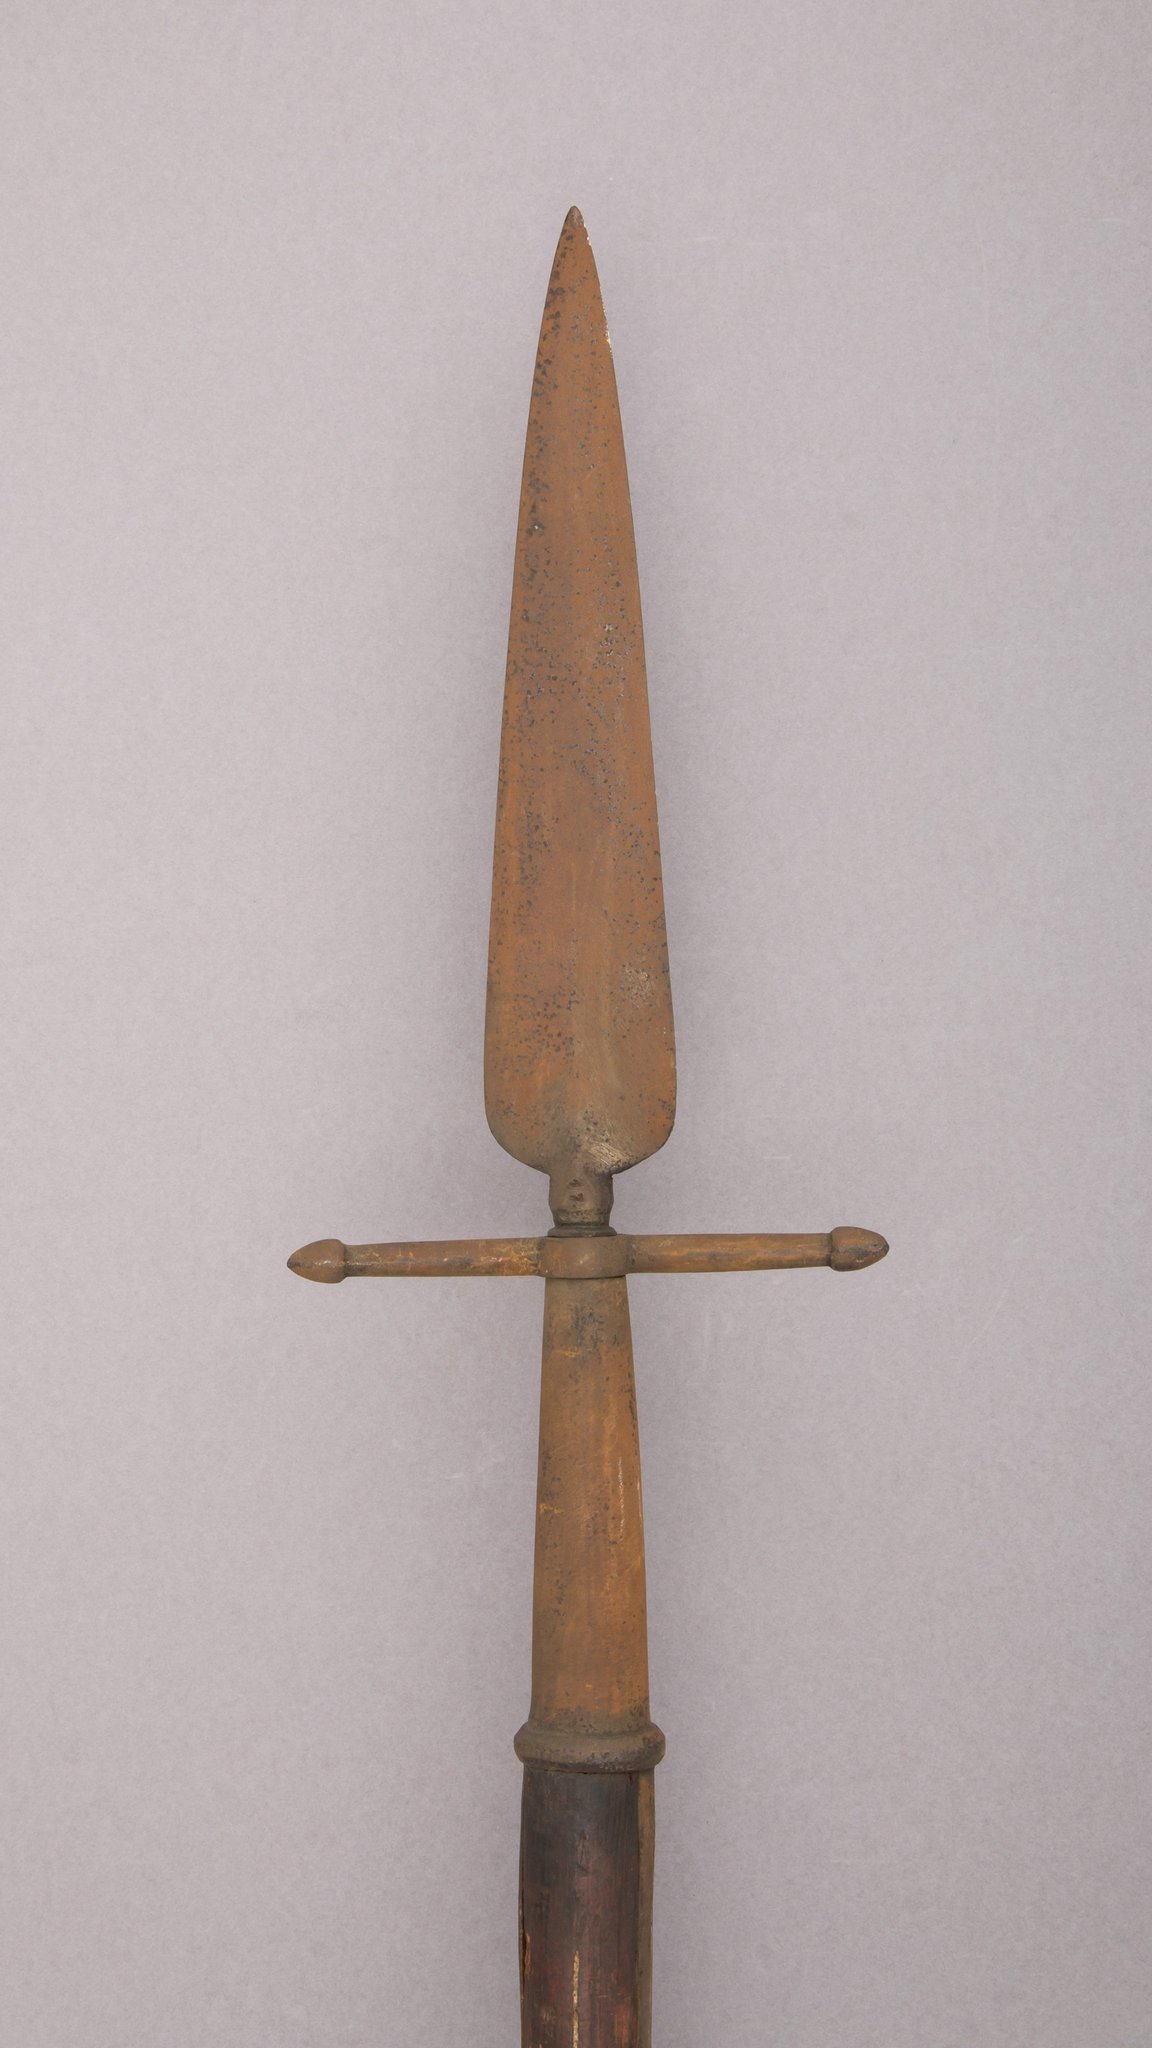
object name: banner with shaft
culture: french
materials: textile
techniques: polychromy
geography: france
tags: men,horses